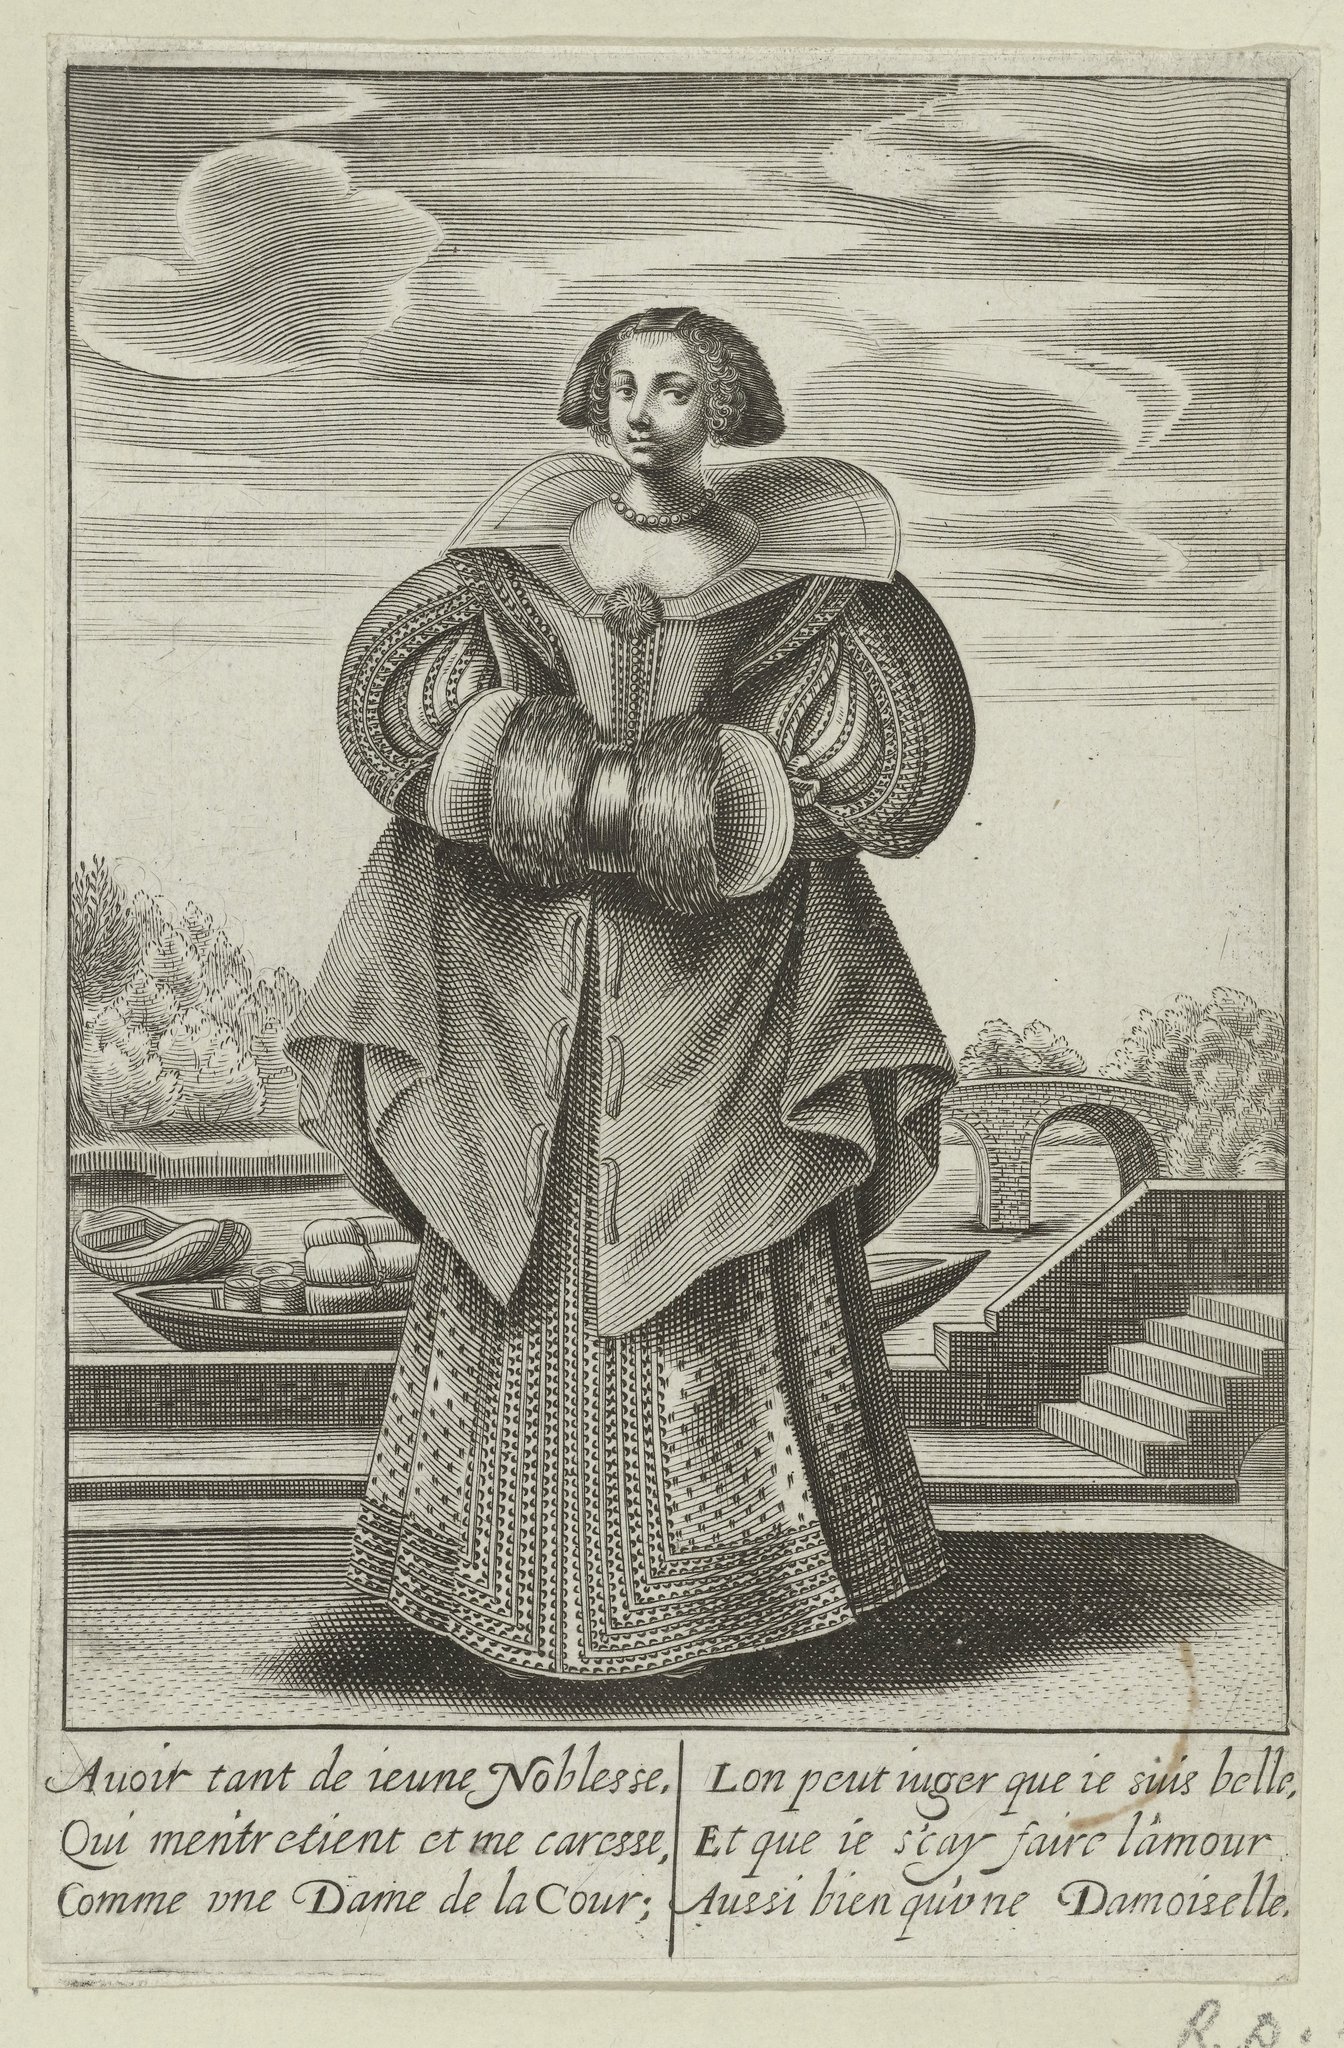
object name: costume print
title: Diversitez d'Habillemens a la mode (...)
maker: isaac briot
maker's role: print maker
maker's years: 1585-1670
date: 1630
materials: paper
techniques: engraving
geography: france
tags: brooch, agraffe, clasp (+ women's clothes), skirt (underskirt) (+ women's clothes), styles of hairdress - aa - ~ women, neck-gear: collar (+ women's clothes), skirt (+ women's clothes), dress, gown (+ women's clothes), clothing for the upper part of the body (with name) (+ women's clothes), royal household; courtiers, retinue, train - bb - female ruler, muff (+ women's clothes)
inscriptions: collector's mark: Lugt 240, caption: ‘Avoir tant de jeune Noblesse / Qui mentretient et une caresse / Comme une Dame de la Cour, / Lon peut iuger que ie suis belle / Et que ie scay faire l 'amour / Aussie bien qu'une Damoiselle.’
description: Franse hofdame van voren gezien, staand op een terras voor een rivier met brug. Ze is gekleed naar de mode aan het hof van Lodewijk XIII, in een overkleed met open pofmouwen afgezet met breed uitstaande manchetten. De rok is opgenomen zodat de onderrok gedeeltelijk zichtbaar is en ze heeft een decolleté met liggende kraag en een schuin uitstaande kraag op de rug met kant. Ze draagt een kort kapsel en een ketting om haar hals en heeft haar handen in een mof.